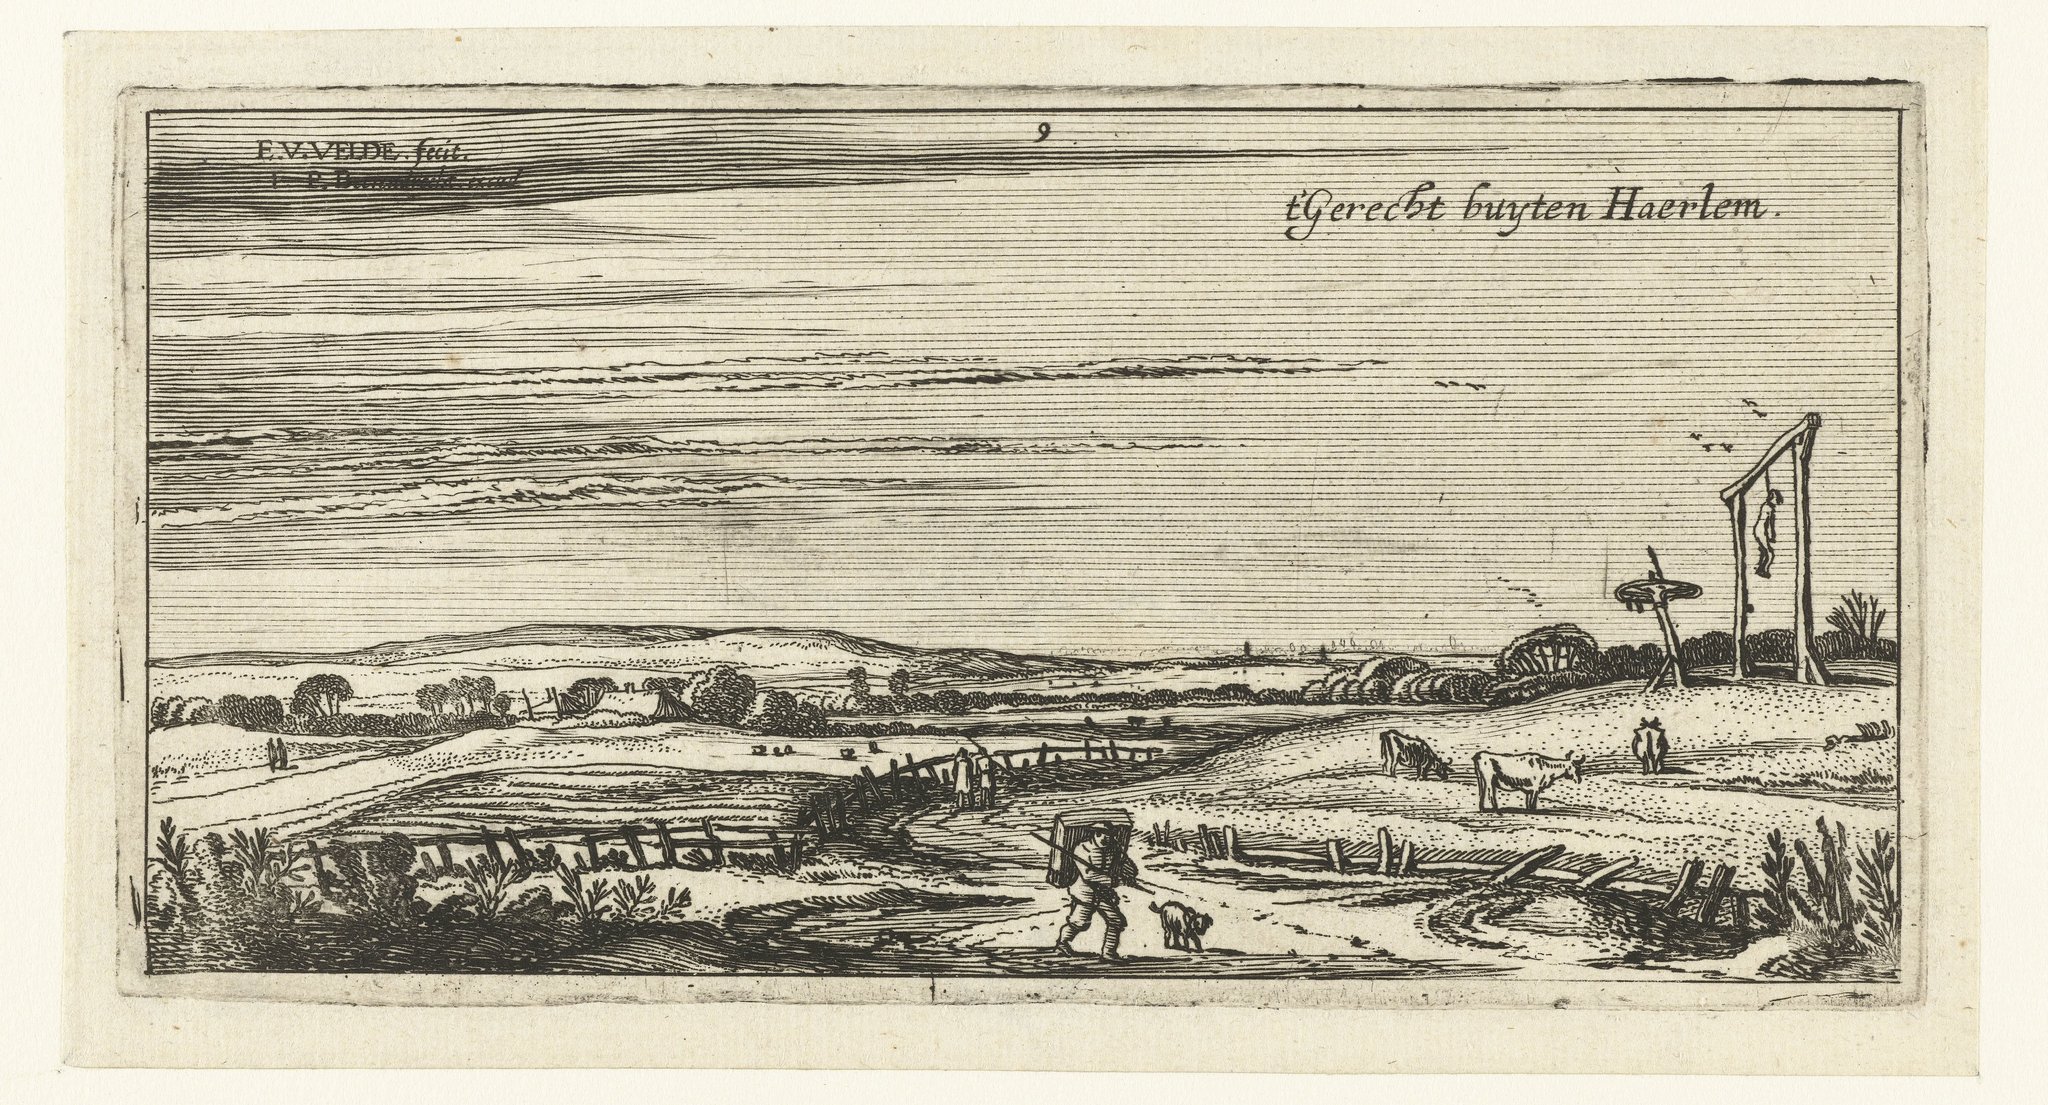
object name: print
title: Landschappen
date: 1615-1616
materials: paper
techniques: engraving, etching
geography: haarlem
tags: violent death by hanging, law and jurisprudence (+ place of execution), haarlem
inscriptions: collector's mark: Lugt 2228a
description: Het opschrift t'Gerecht buyten Haerlem plaatst dit landschap met galgenveld in de omgeving van Haarlem